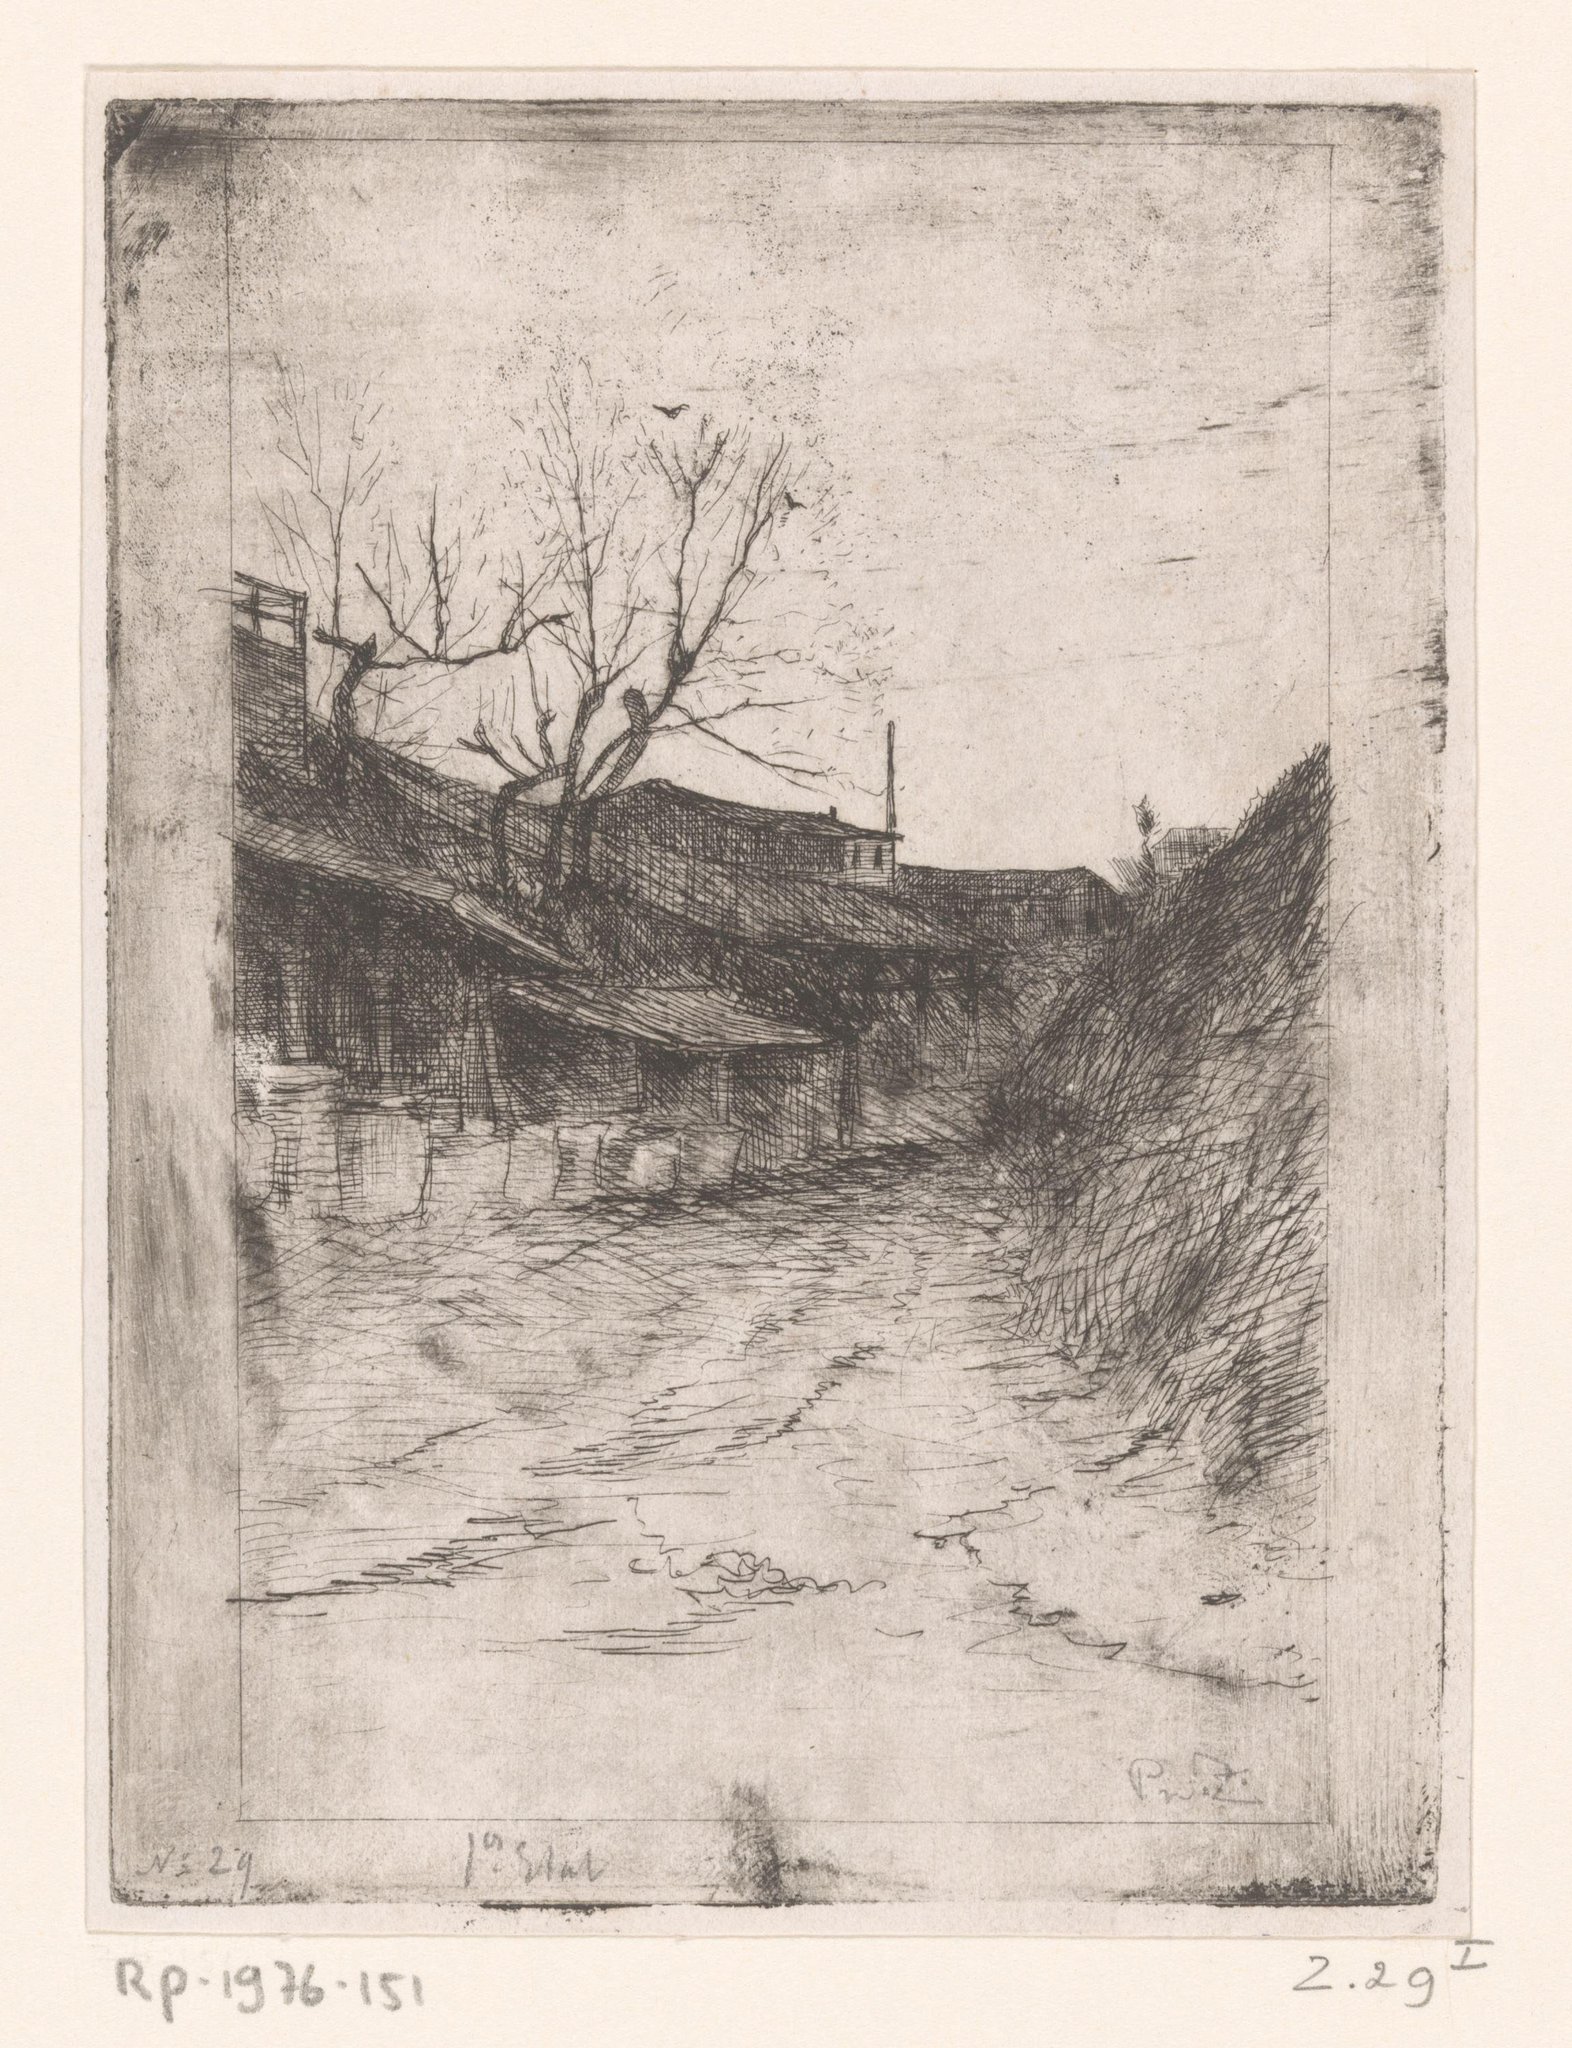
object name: print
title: La Bièvre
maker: philip zilcken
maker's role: draughtsman, painter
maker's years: 1857-1930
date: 1867-1890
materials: paper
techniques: drypoint, etching, intaglio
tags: trees, edifice, e.g.: public building, department store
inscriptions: collector's mark: Lugt 2228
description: Op verso een schets van het hoofd van een vrouw.